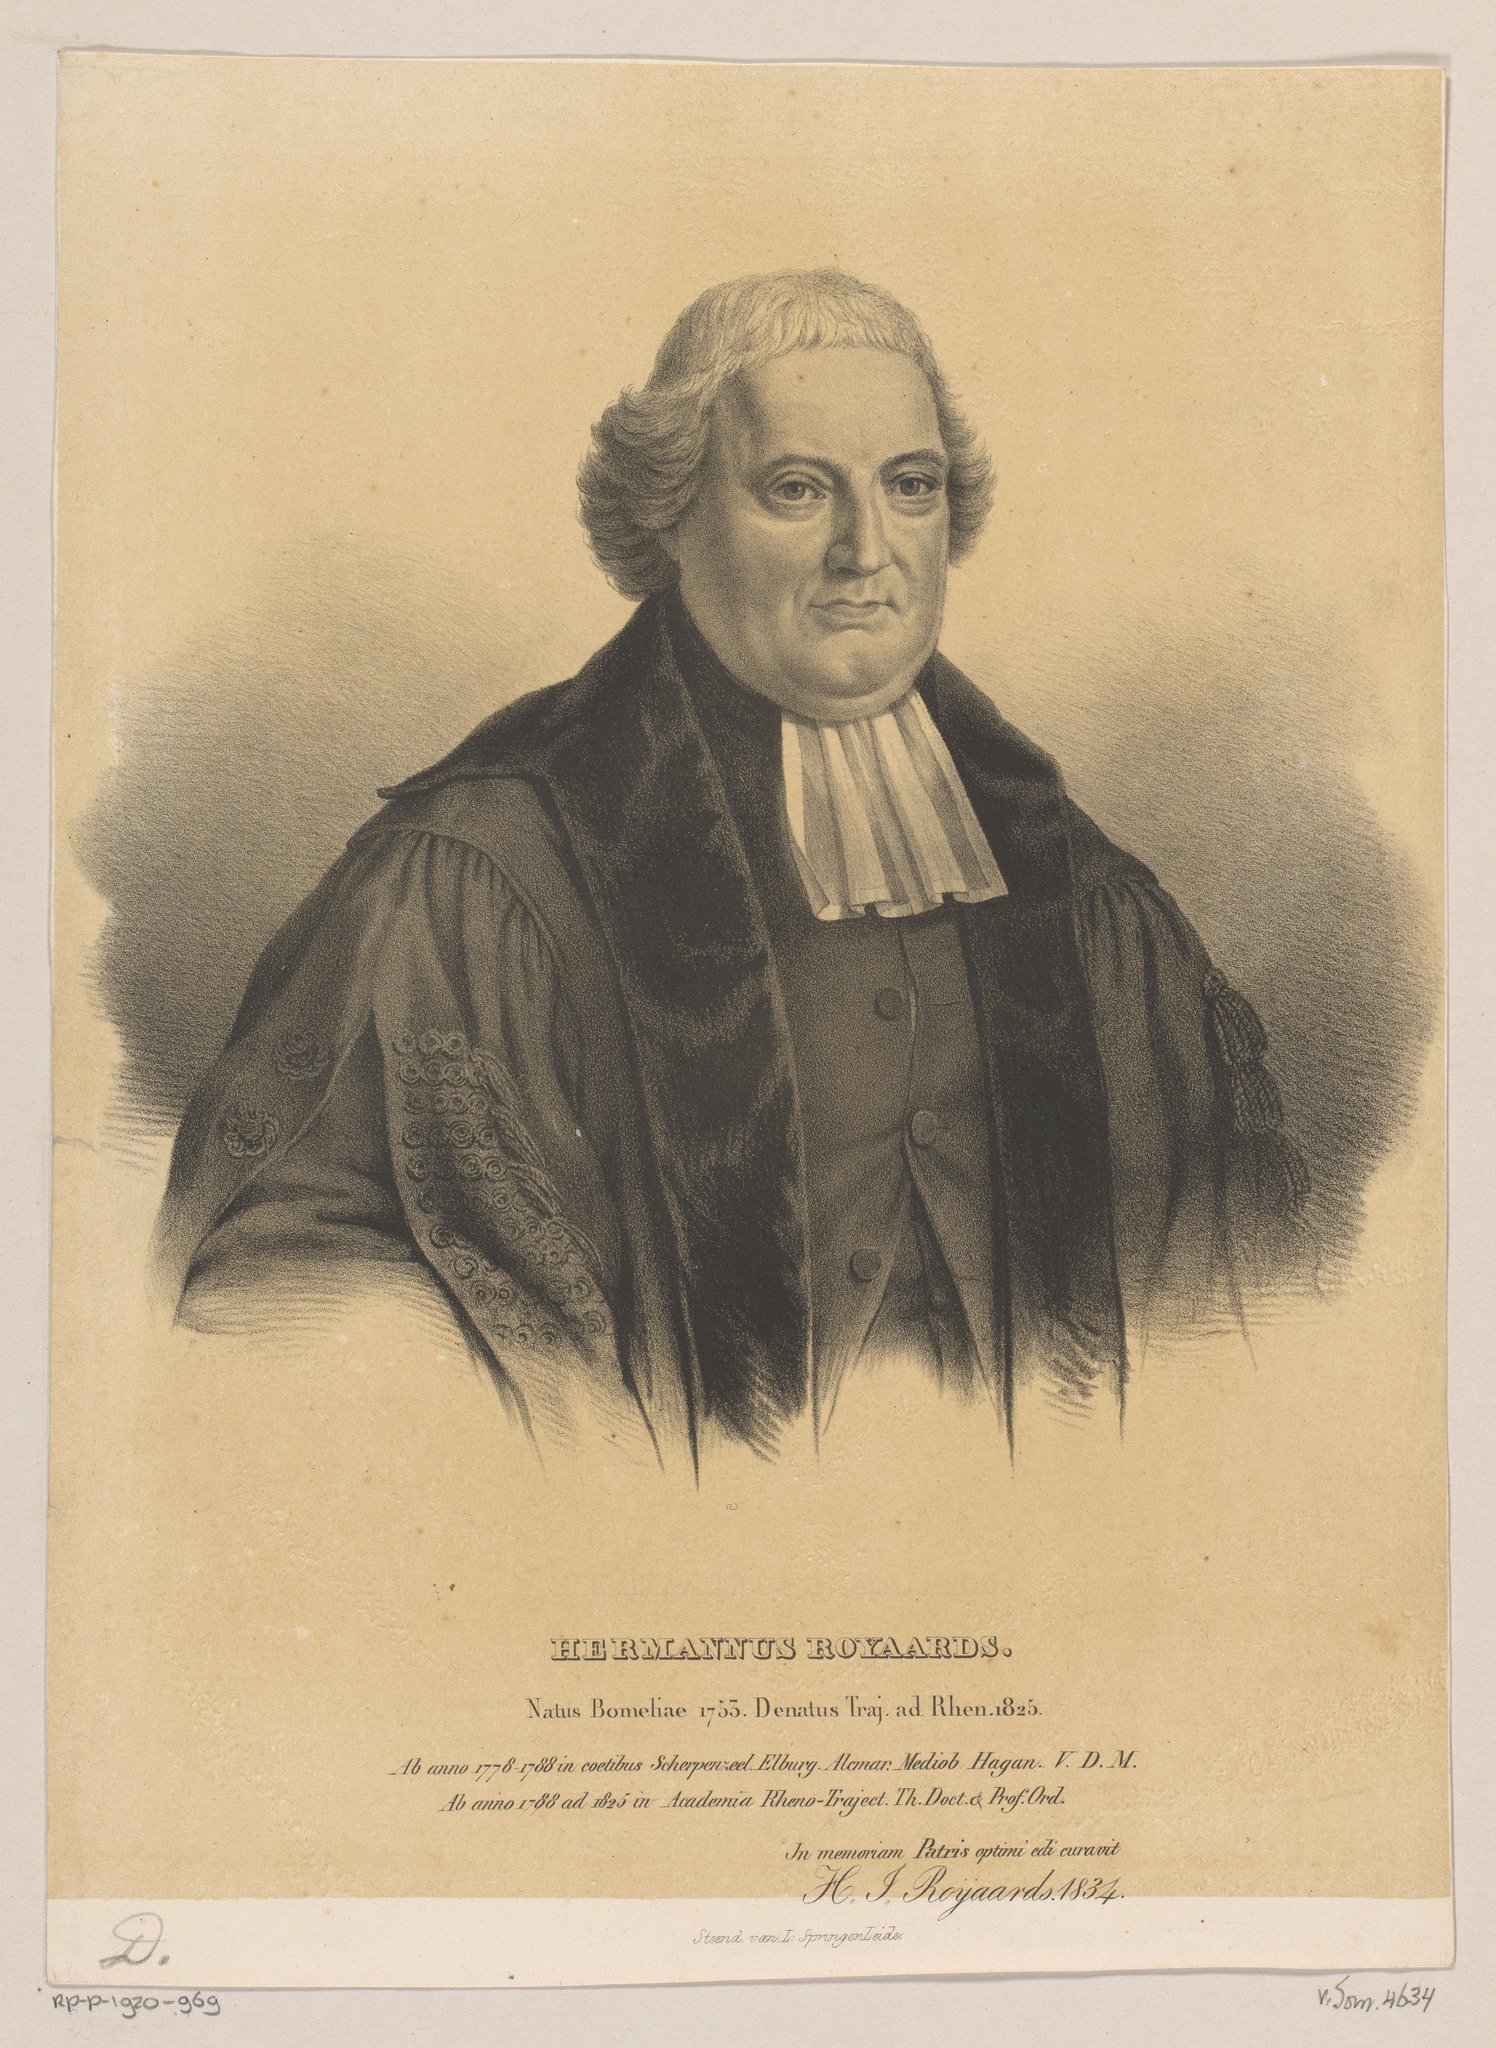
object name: print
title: Portret van Hermannus Royaards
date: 1834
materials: paper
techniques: tone lithography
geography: leiden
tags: theologian, historical persons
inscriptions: collector's mark: Lugt 2228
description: Met vierregelig onderschrift in het Latijn.